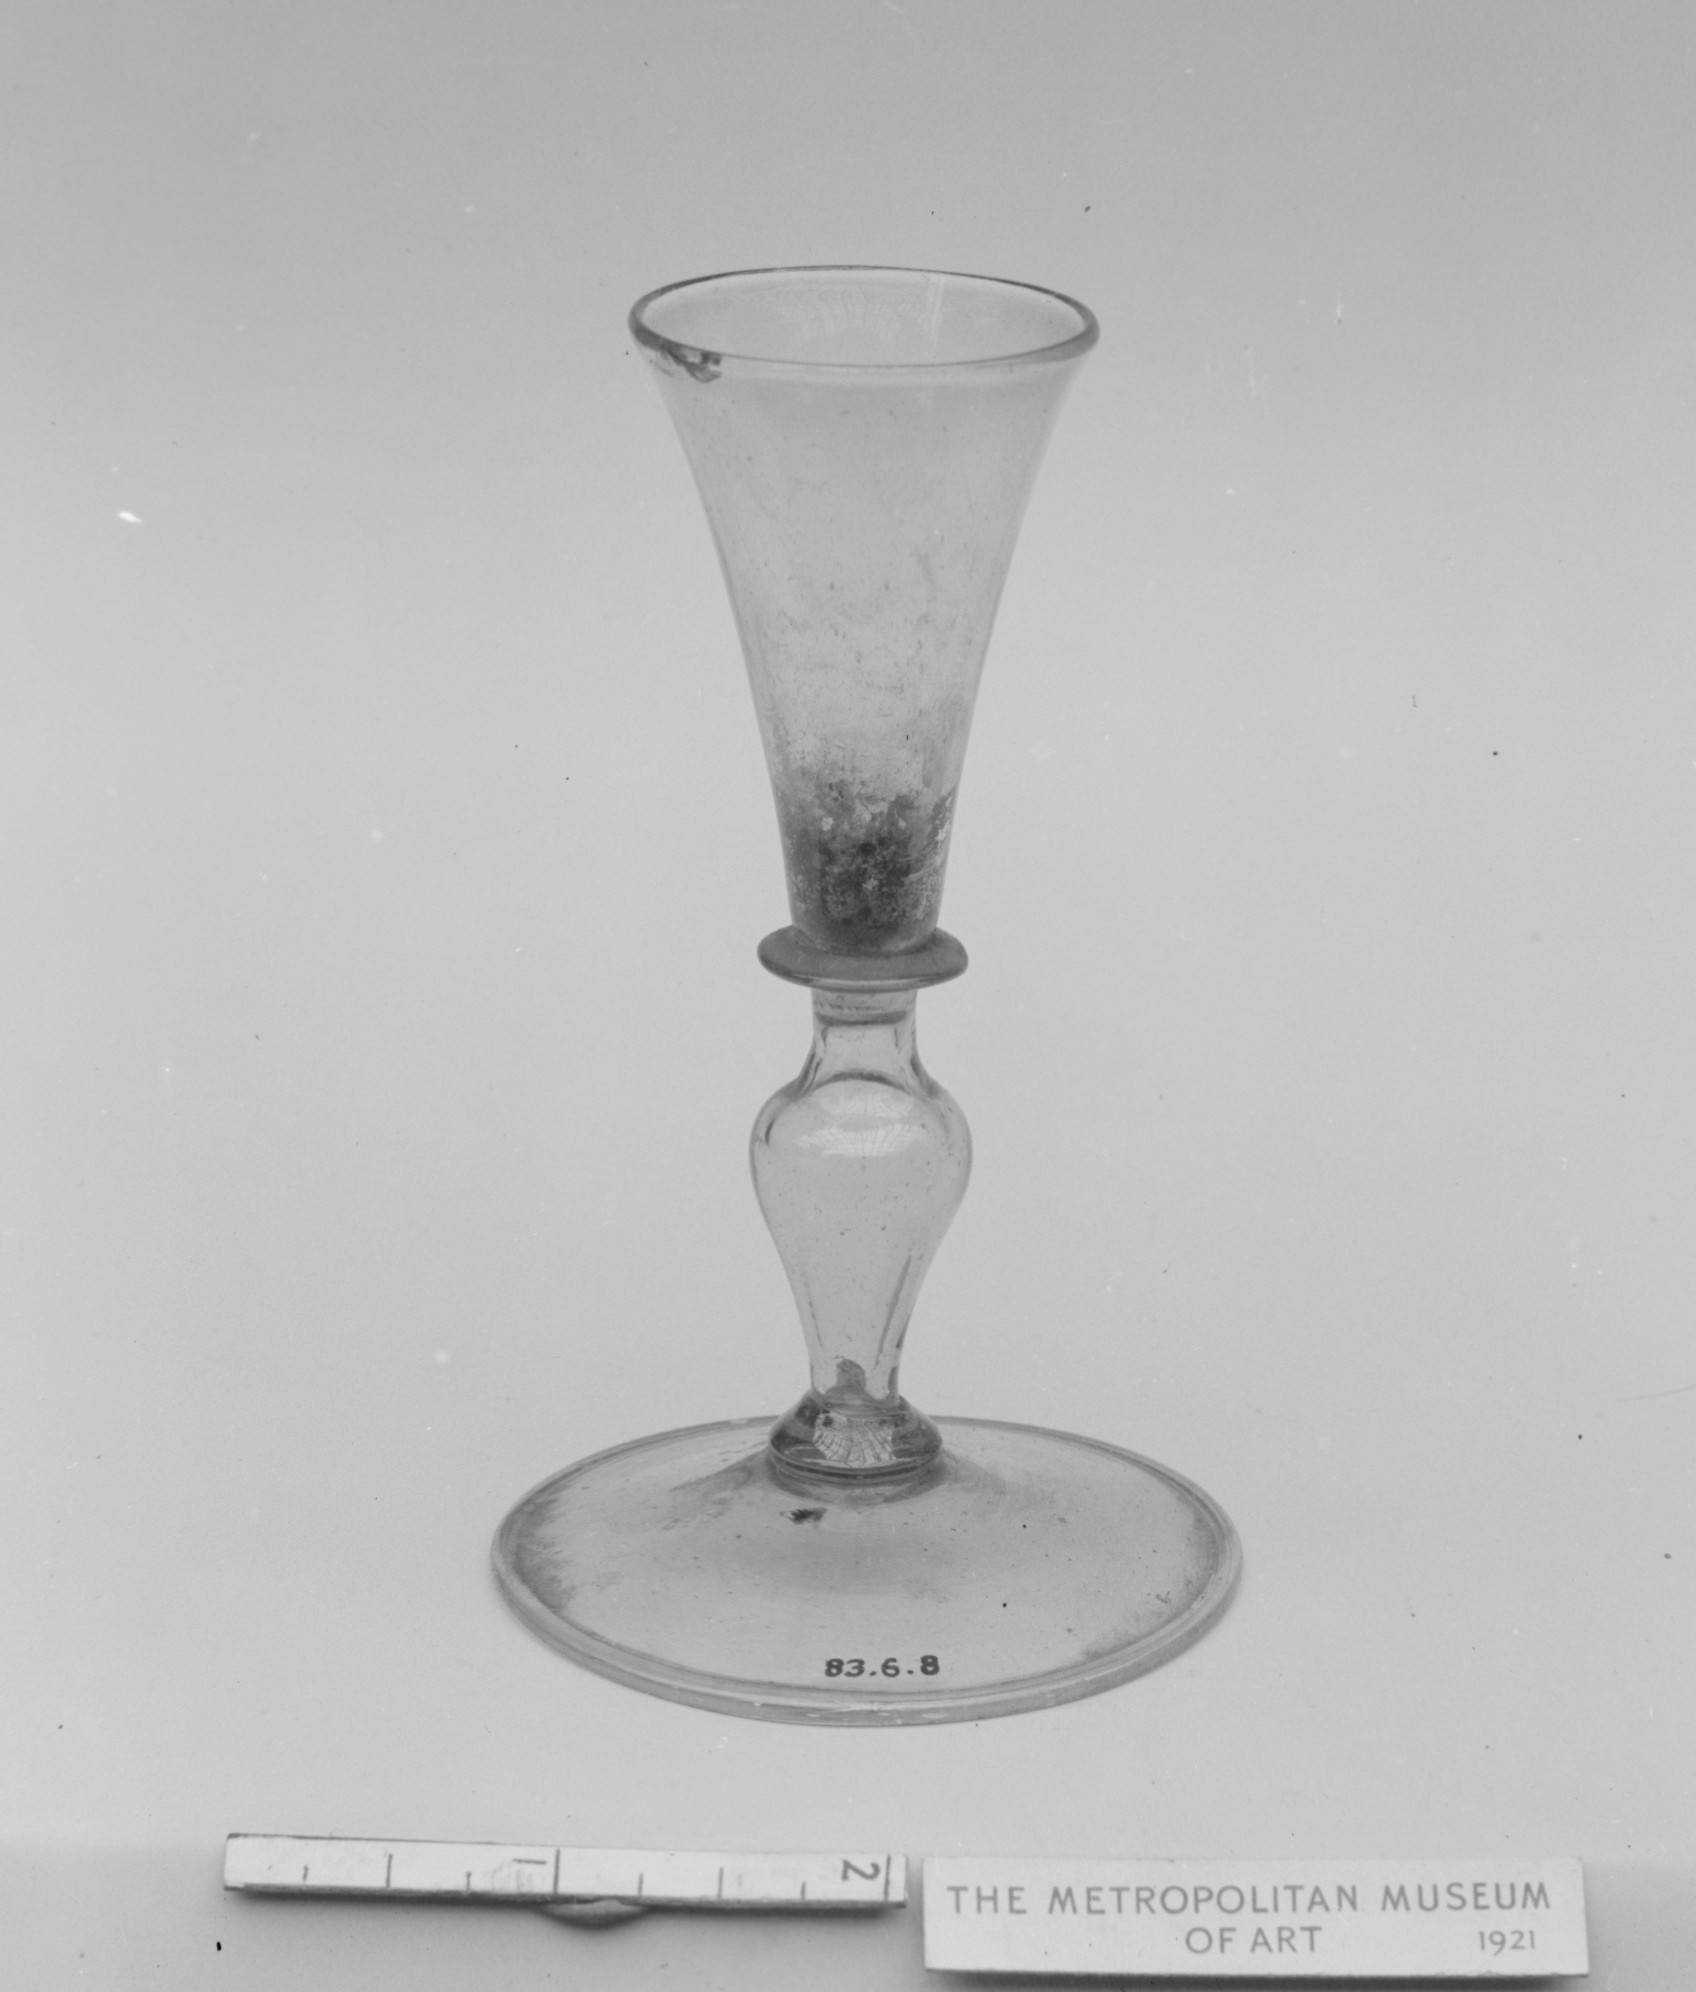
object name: cordial glass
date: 1601-1800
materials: glass